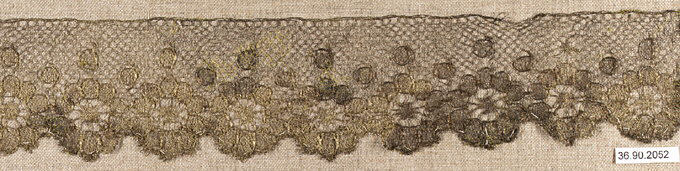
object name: piece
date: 1701-1800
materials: metal thread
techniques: lace